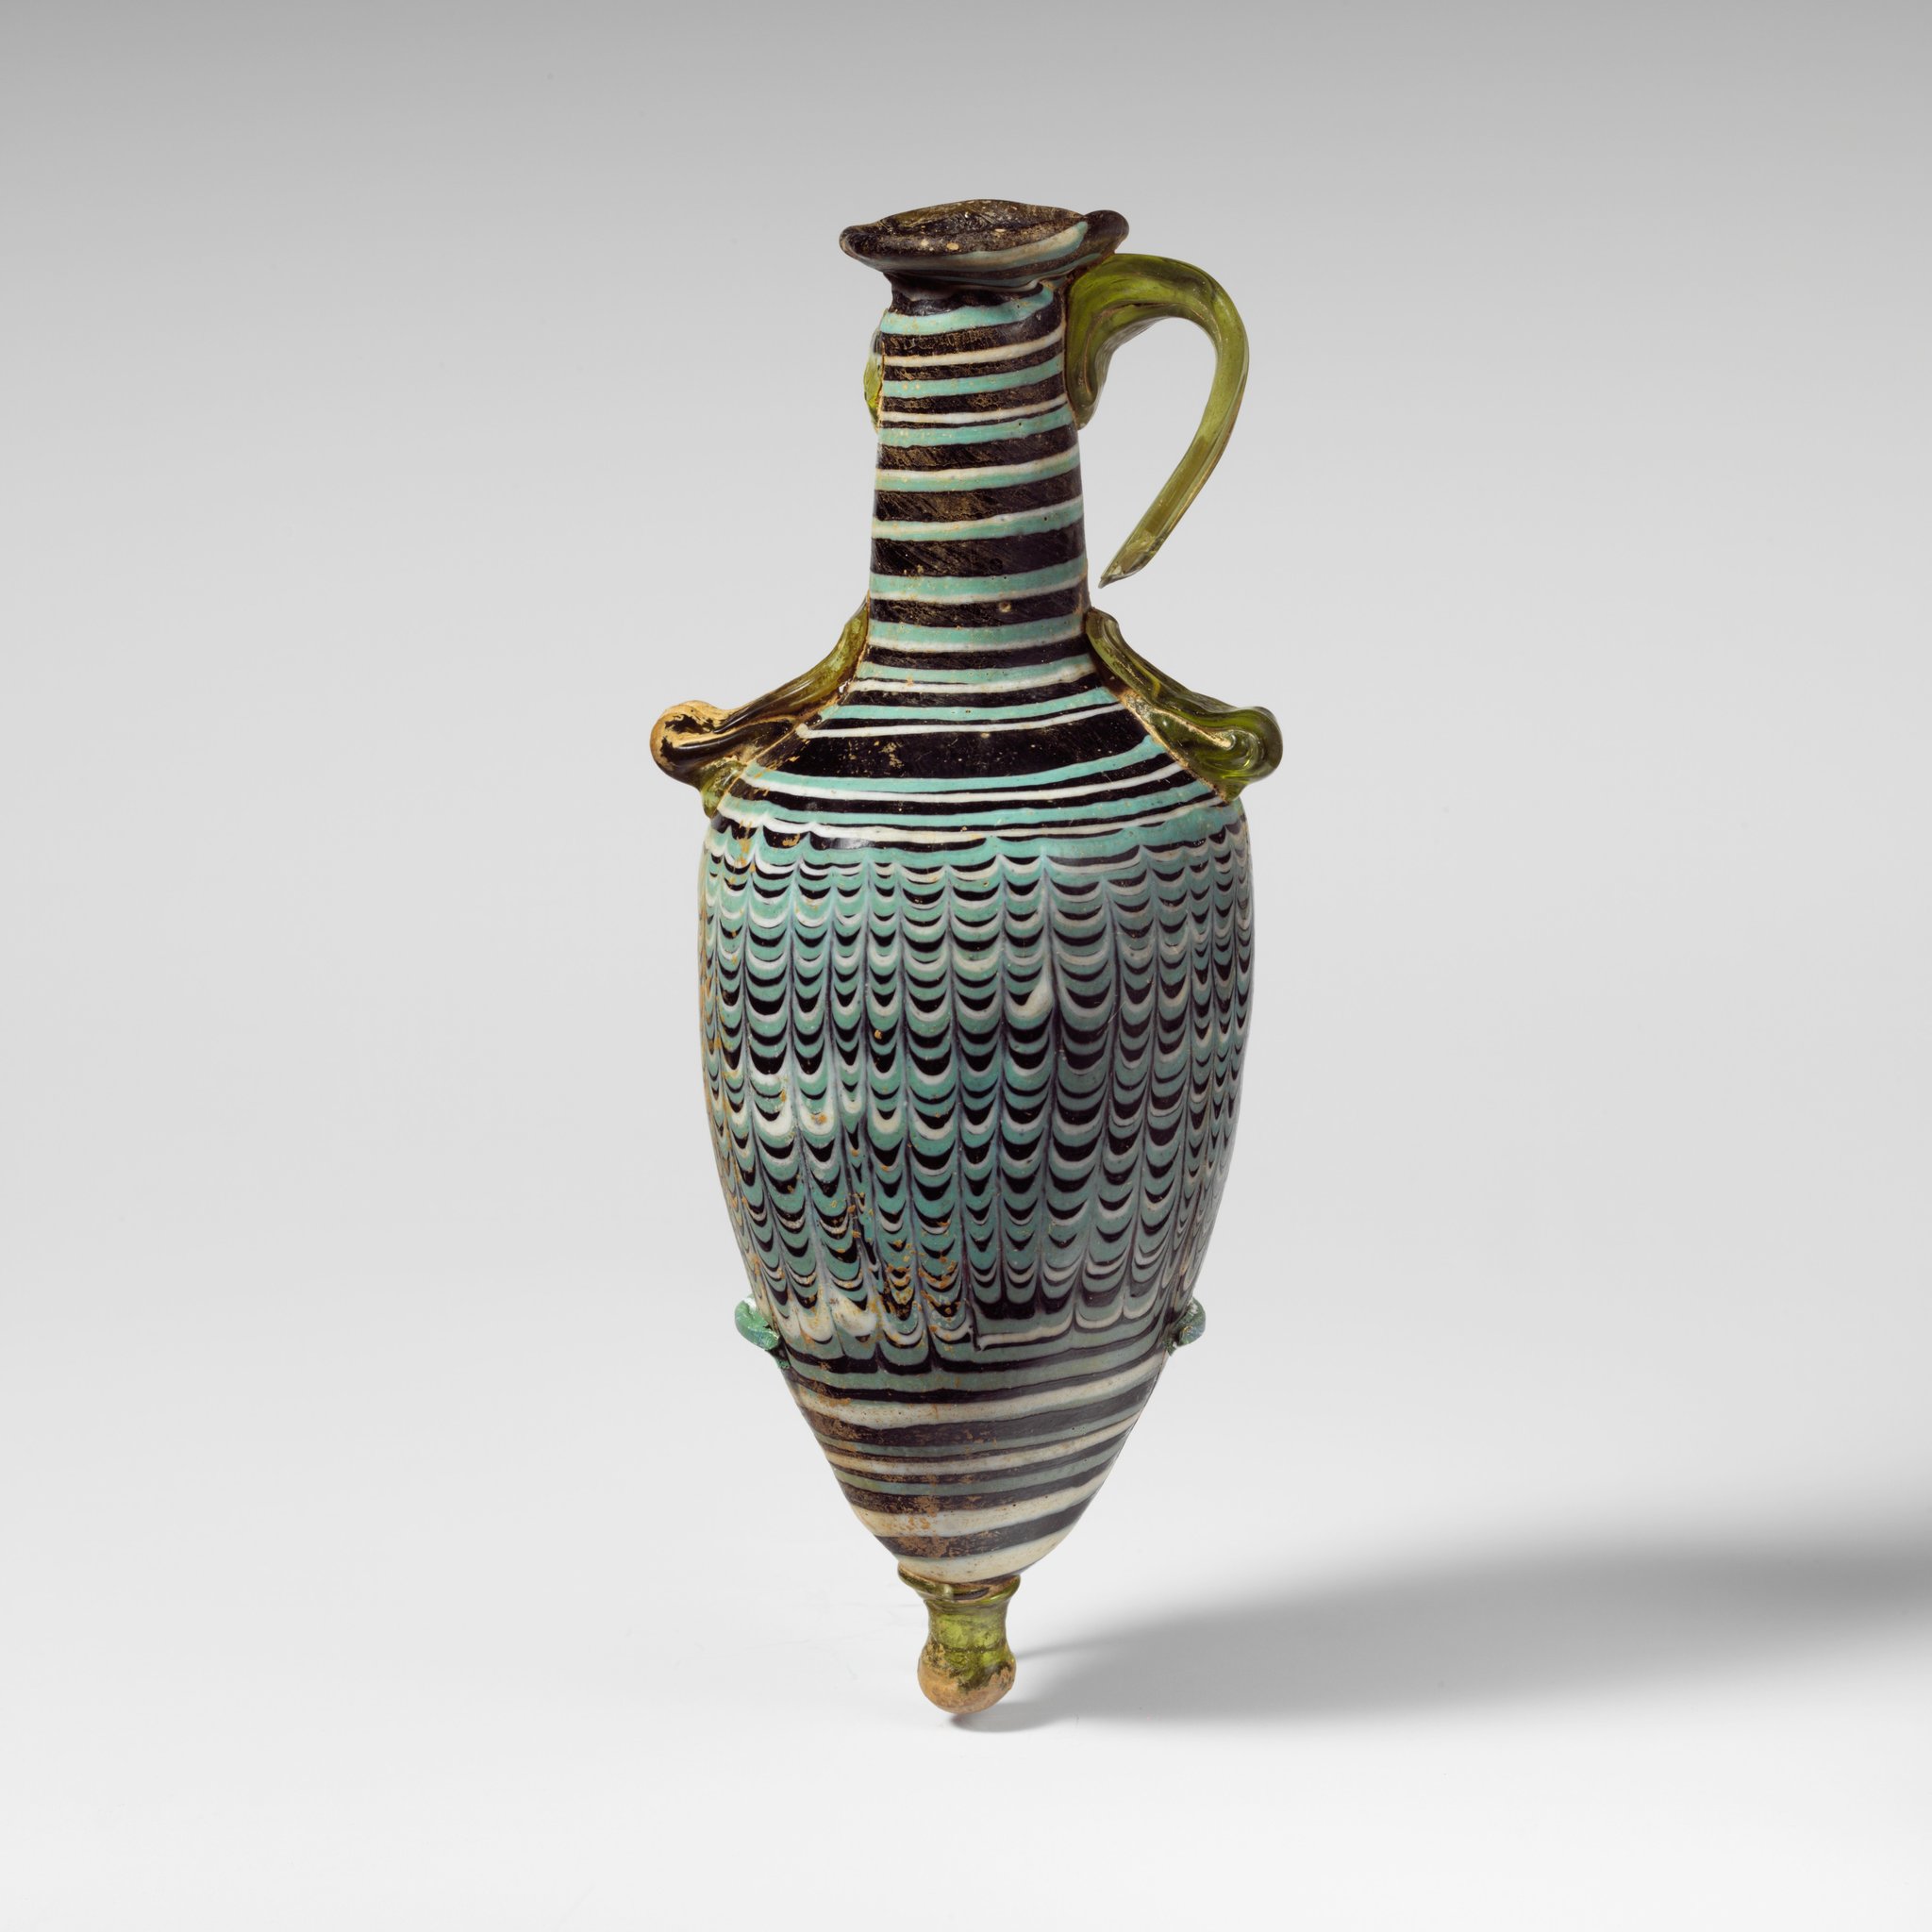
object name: amphoriskos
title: Glass amphoriskos (perfume bottle)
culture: greek, eastern mediterranean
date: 200-1 BCE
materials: glass